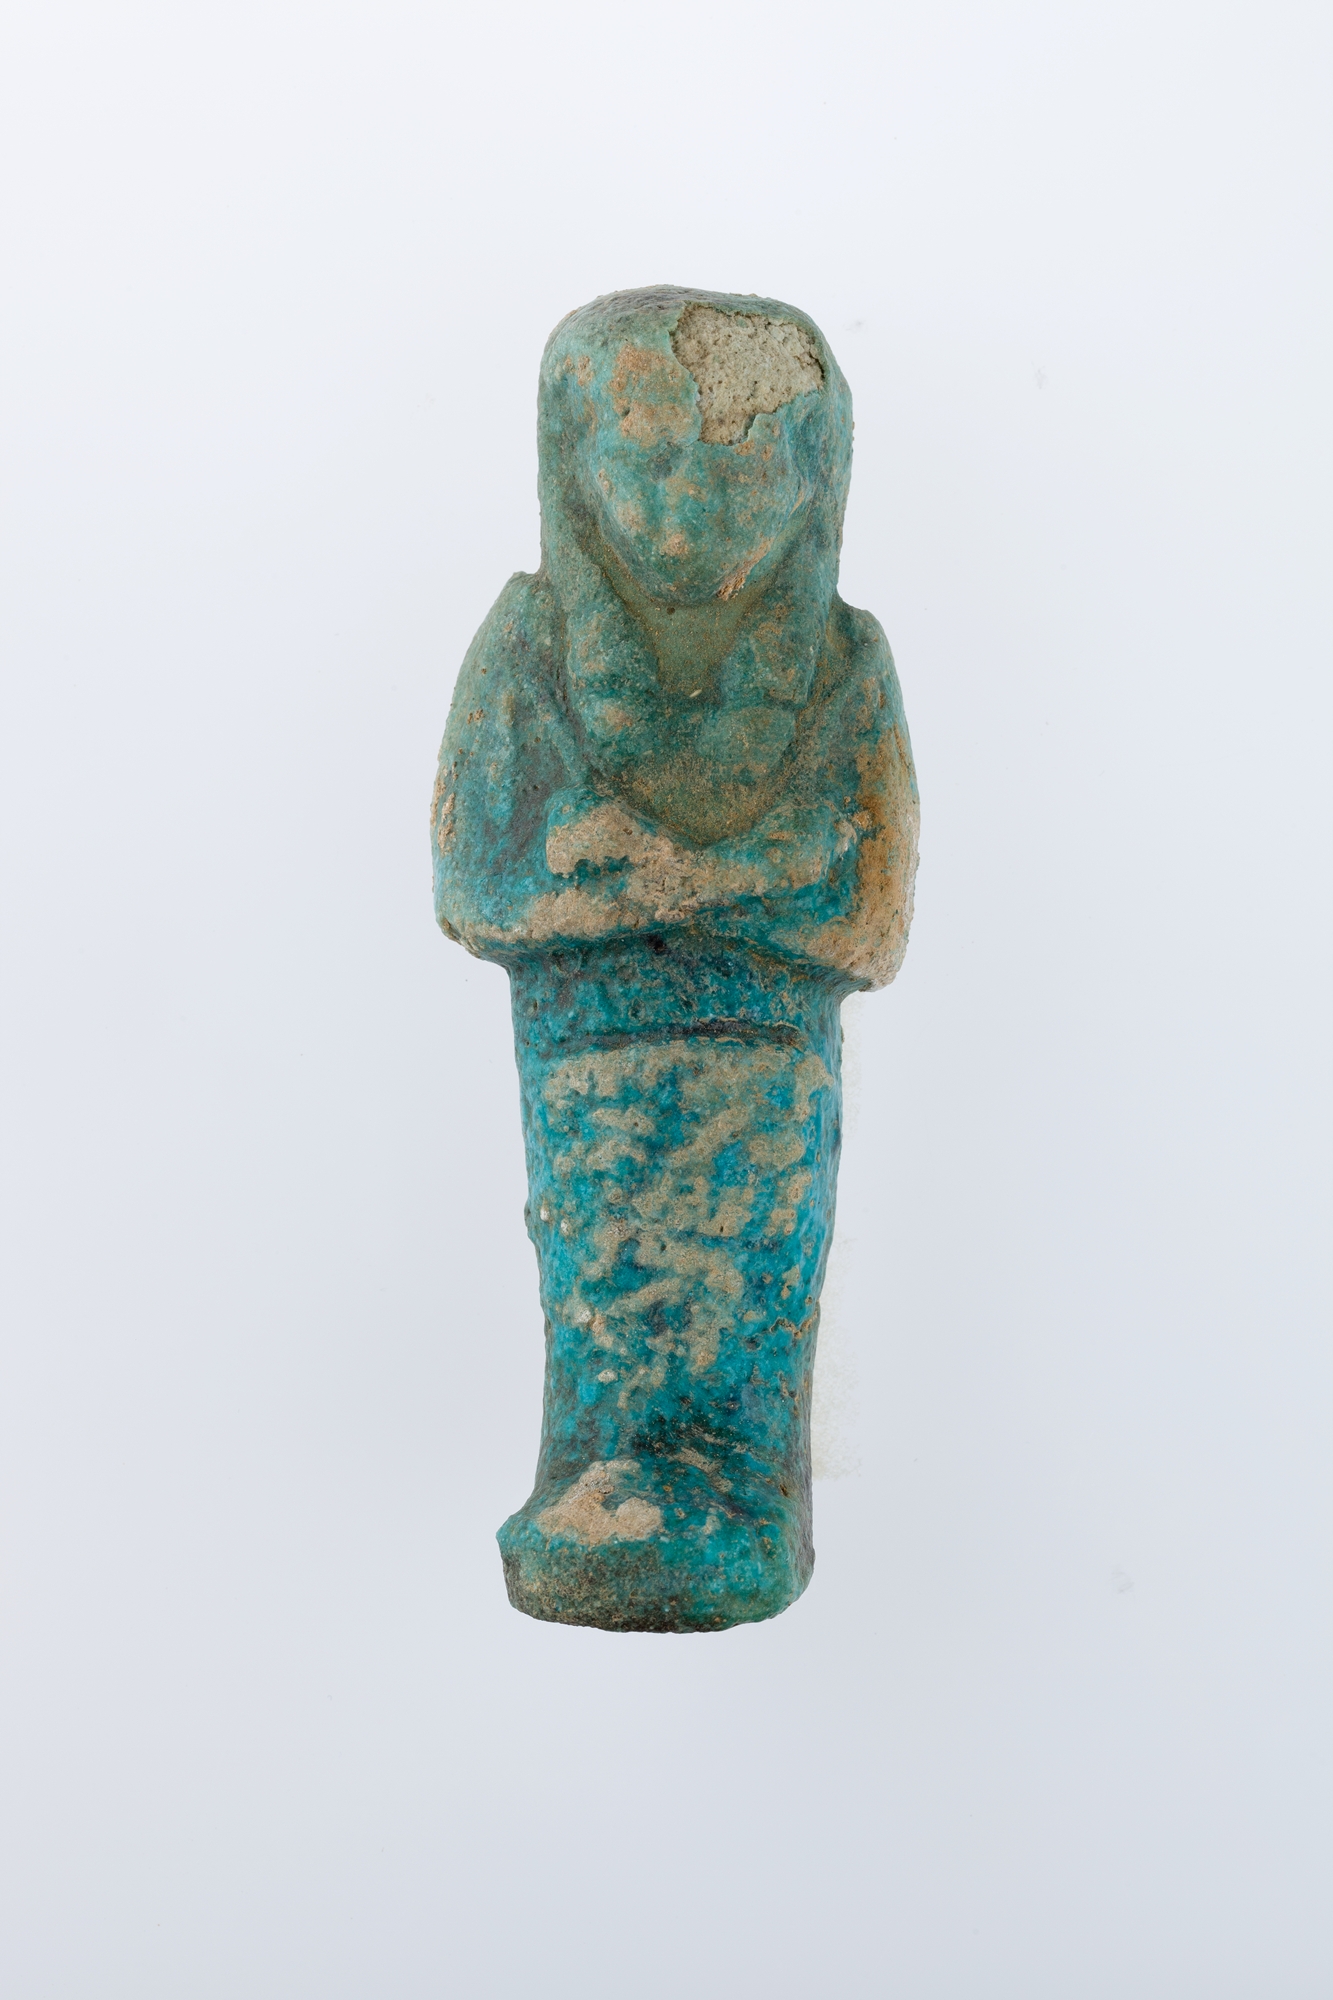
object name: shabti, henettawy c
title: Worker Shabti of Henettawy (C), Daughter of Isetemkheb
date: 990-970 BCE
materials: faience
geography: egypt